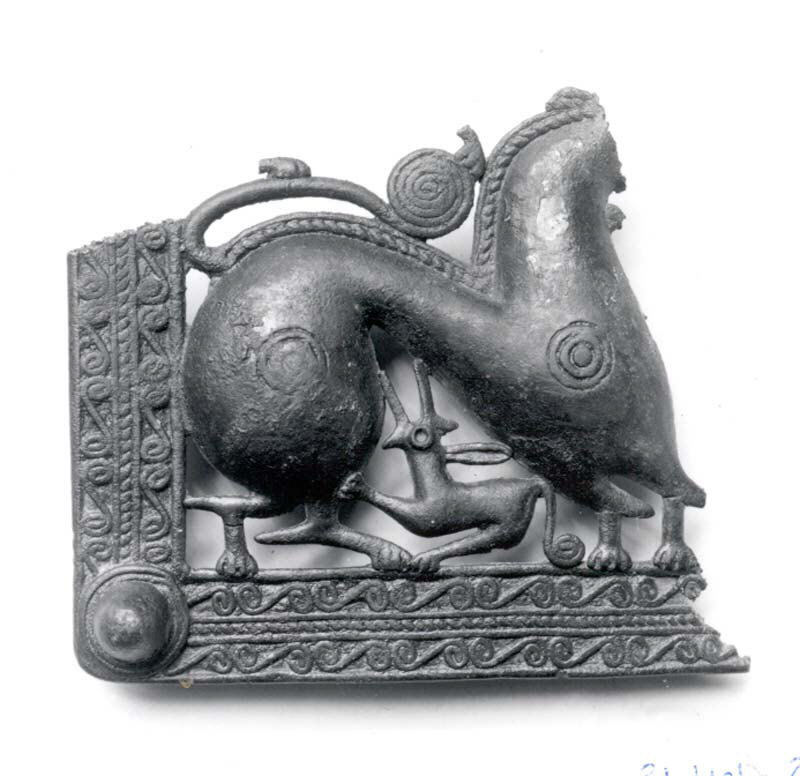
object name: belt clasp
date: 1-200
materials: brass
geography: transcaucasia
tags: animals